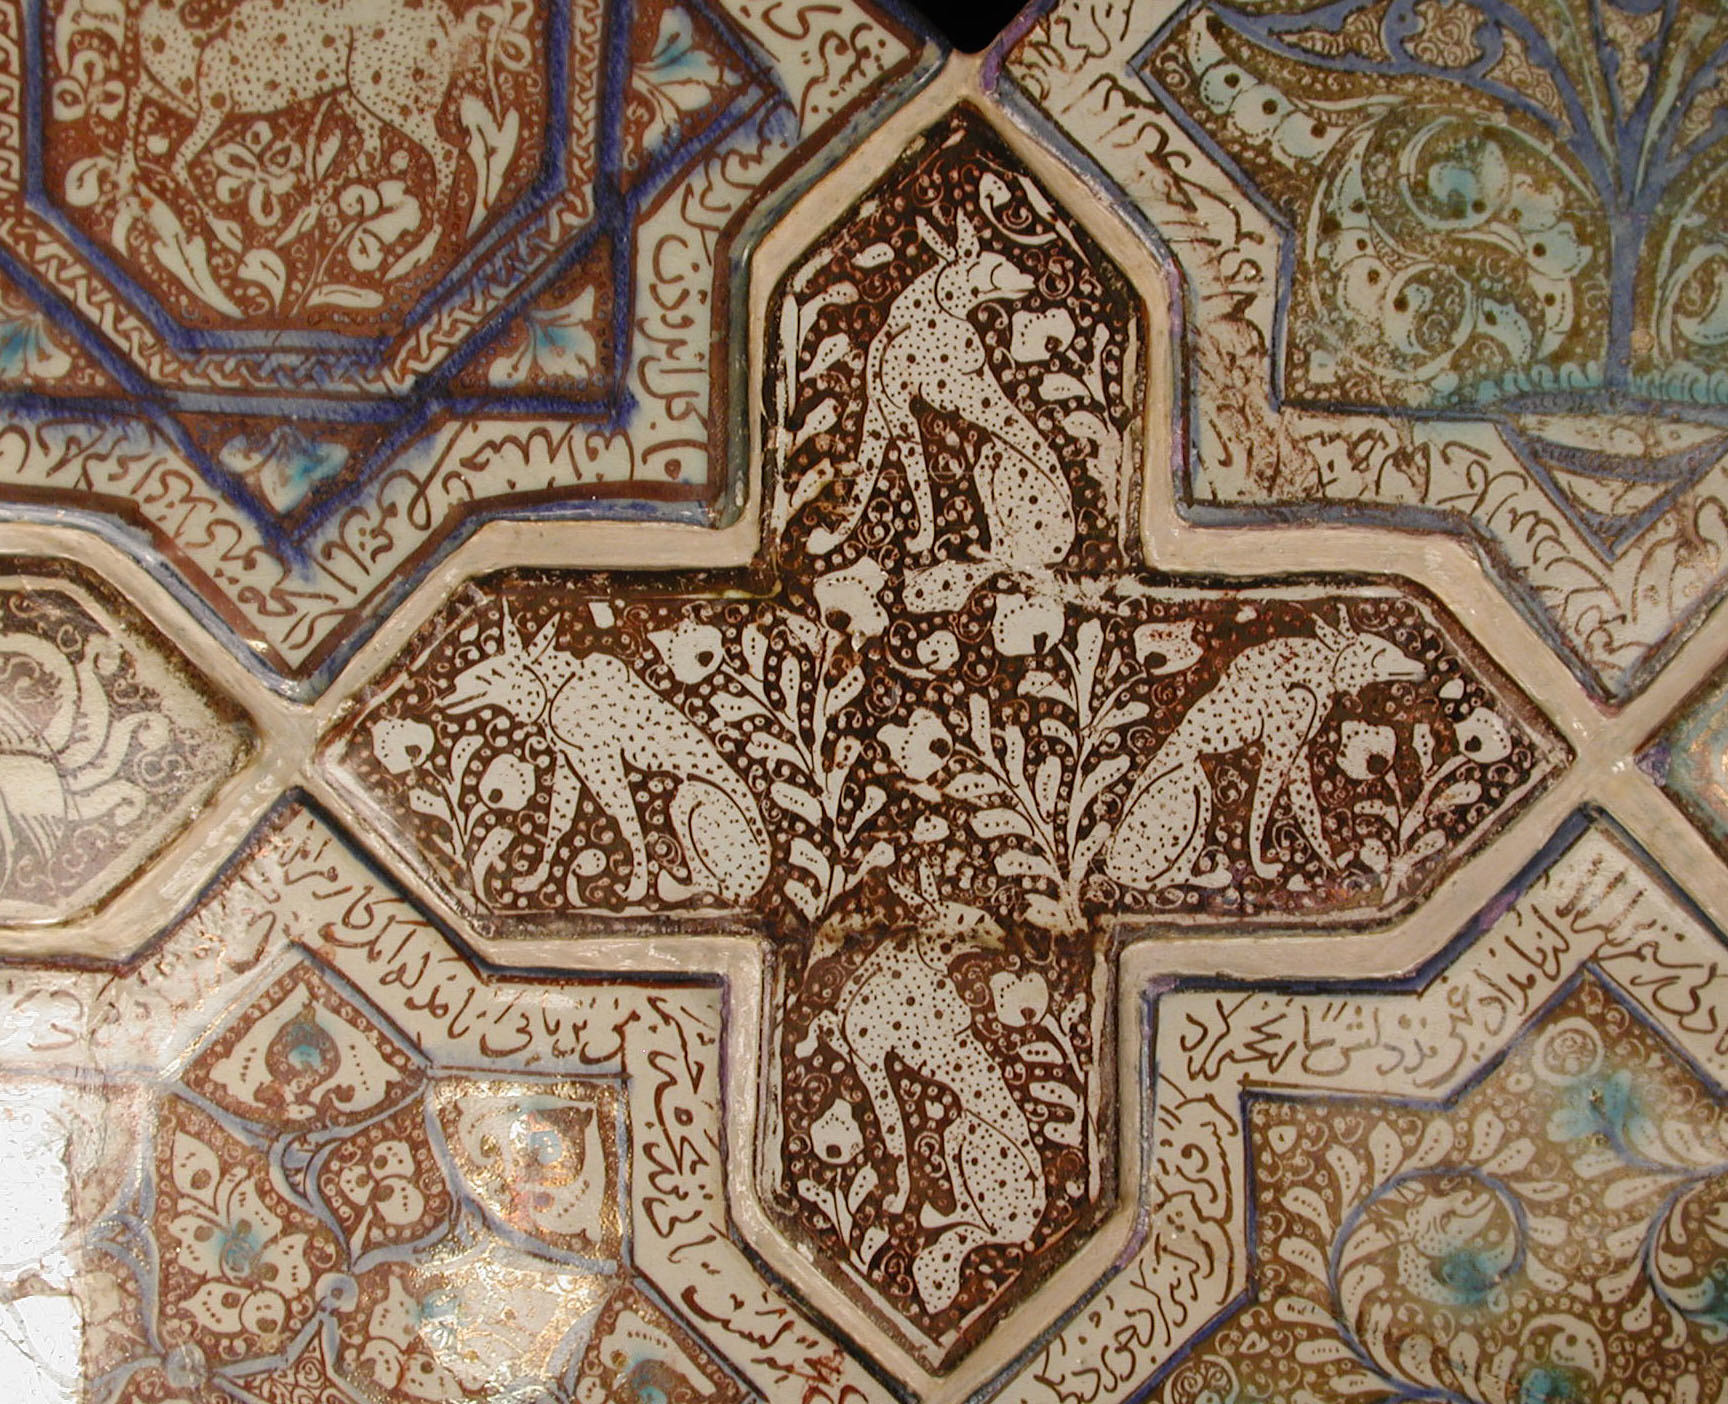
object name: tile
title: Cross-Shaped Tile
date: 1201-1300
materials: glaze, stonepaste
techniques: luster painting, painting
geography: iran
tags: animals